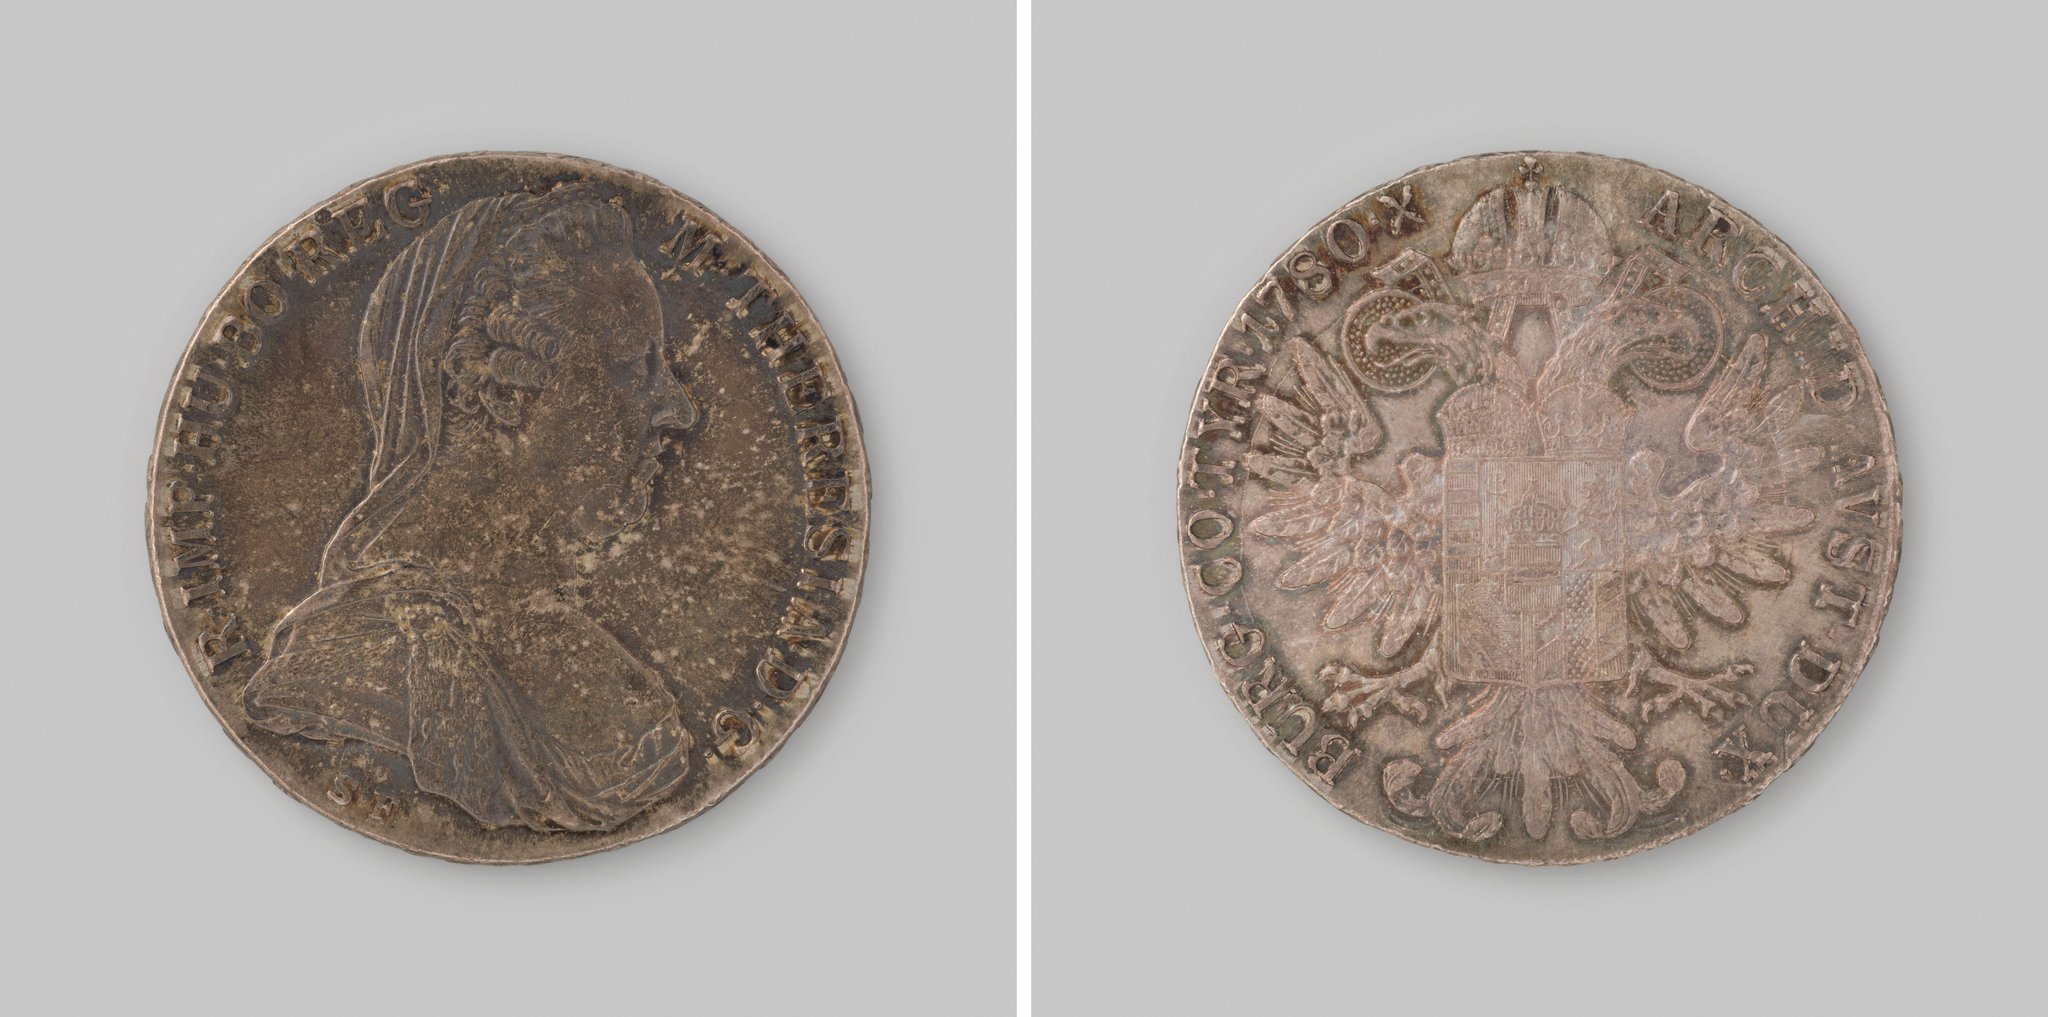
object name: coin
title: Naslag van Maria Theresia-daalder met jaartal 1780, bestemd voor Noord-Oost-Afrika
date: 1780-1975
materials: silver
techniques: striking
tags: maria theresia (rooms-duits keizerin)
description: Zilveren munt. Voorzijde: borstbeeld van keizerin Maria-Theresia van Oostenrijk-Hongarije met sluier, naar rechts. Onder borstbeeld lettters S. en F. {aanduidingen van muntmeesters in Gunzburg in Oostenrijks gebied Burgau bij Ulm]. Keerzijde: met keizerskroon gekroonde tweekoppige adelaar met op zijn borst van twee kronen voorzien samengesteld wapenschild van Oostenrijk-Hongarije. Aan het eind van het opschrift bevroren jaartal 1780, waarachter kruis van knoestige stokken. Randschrift. Deze naslagen zijn vooral in Wenen geslagen.